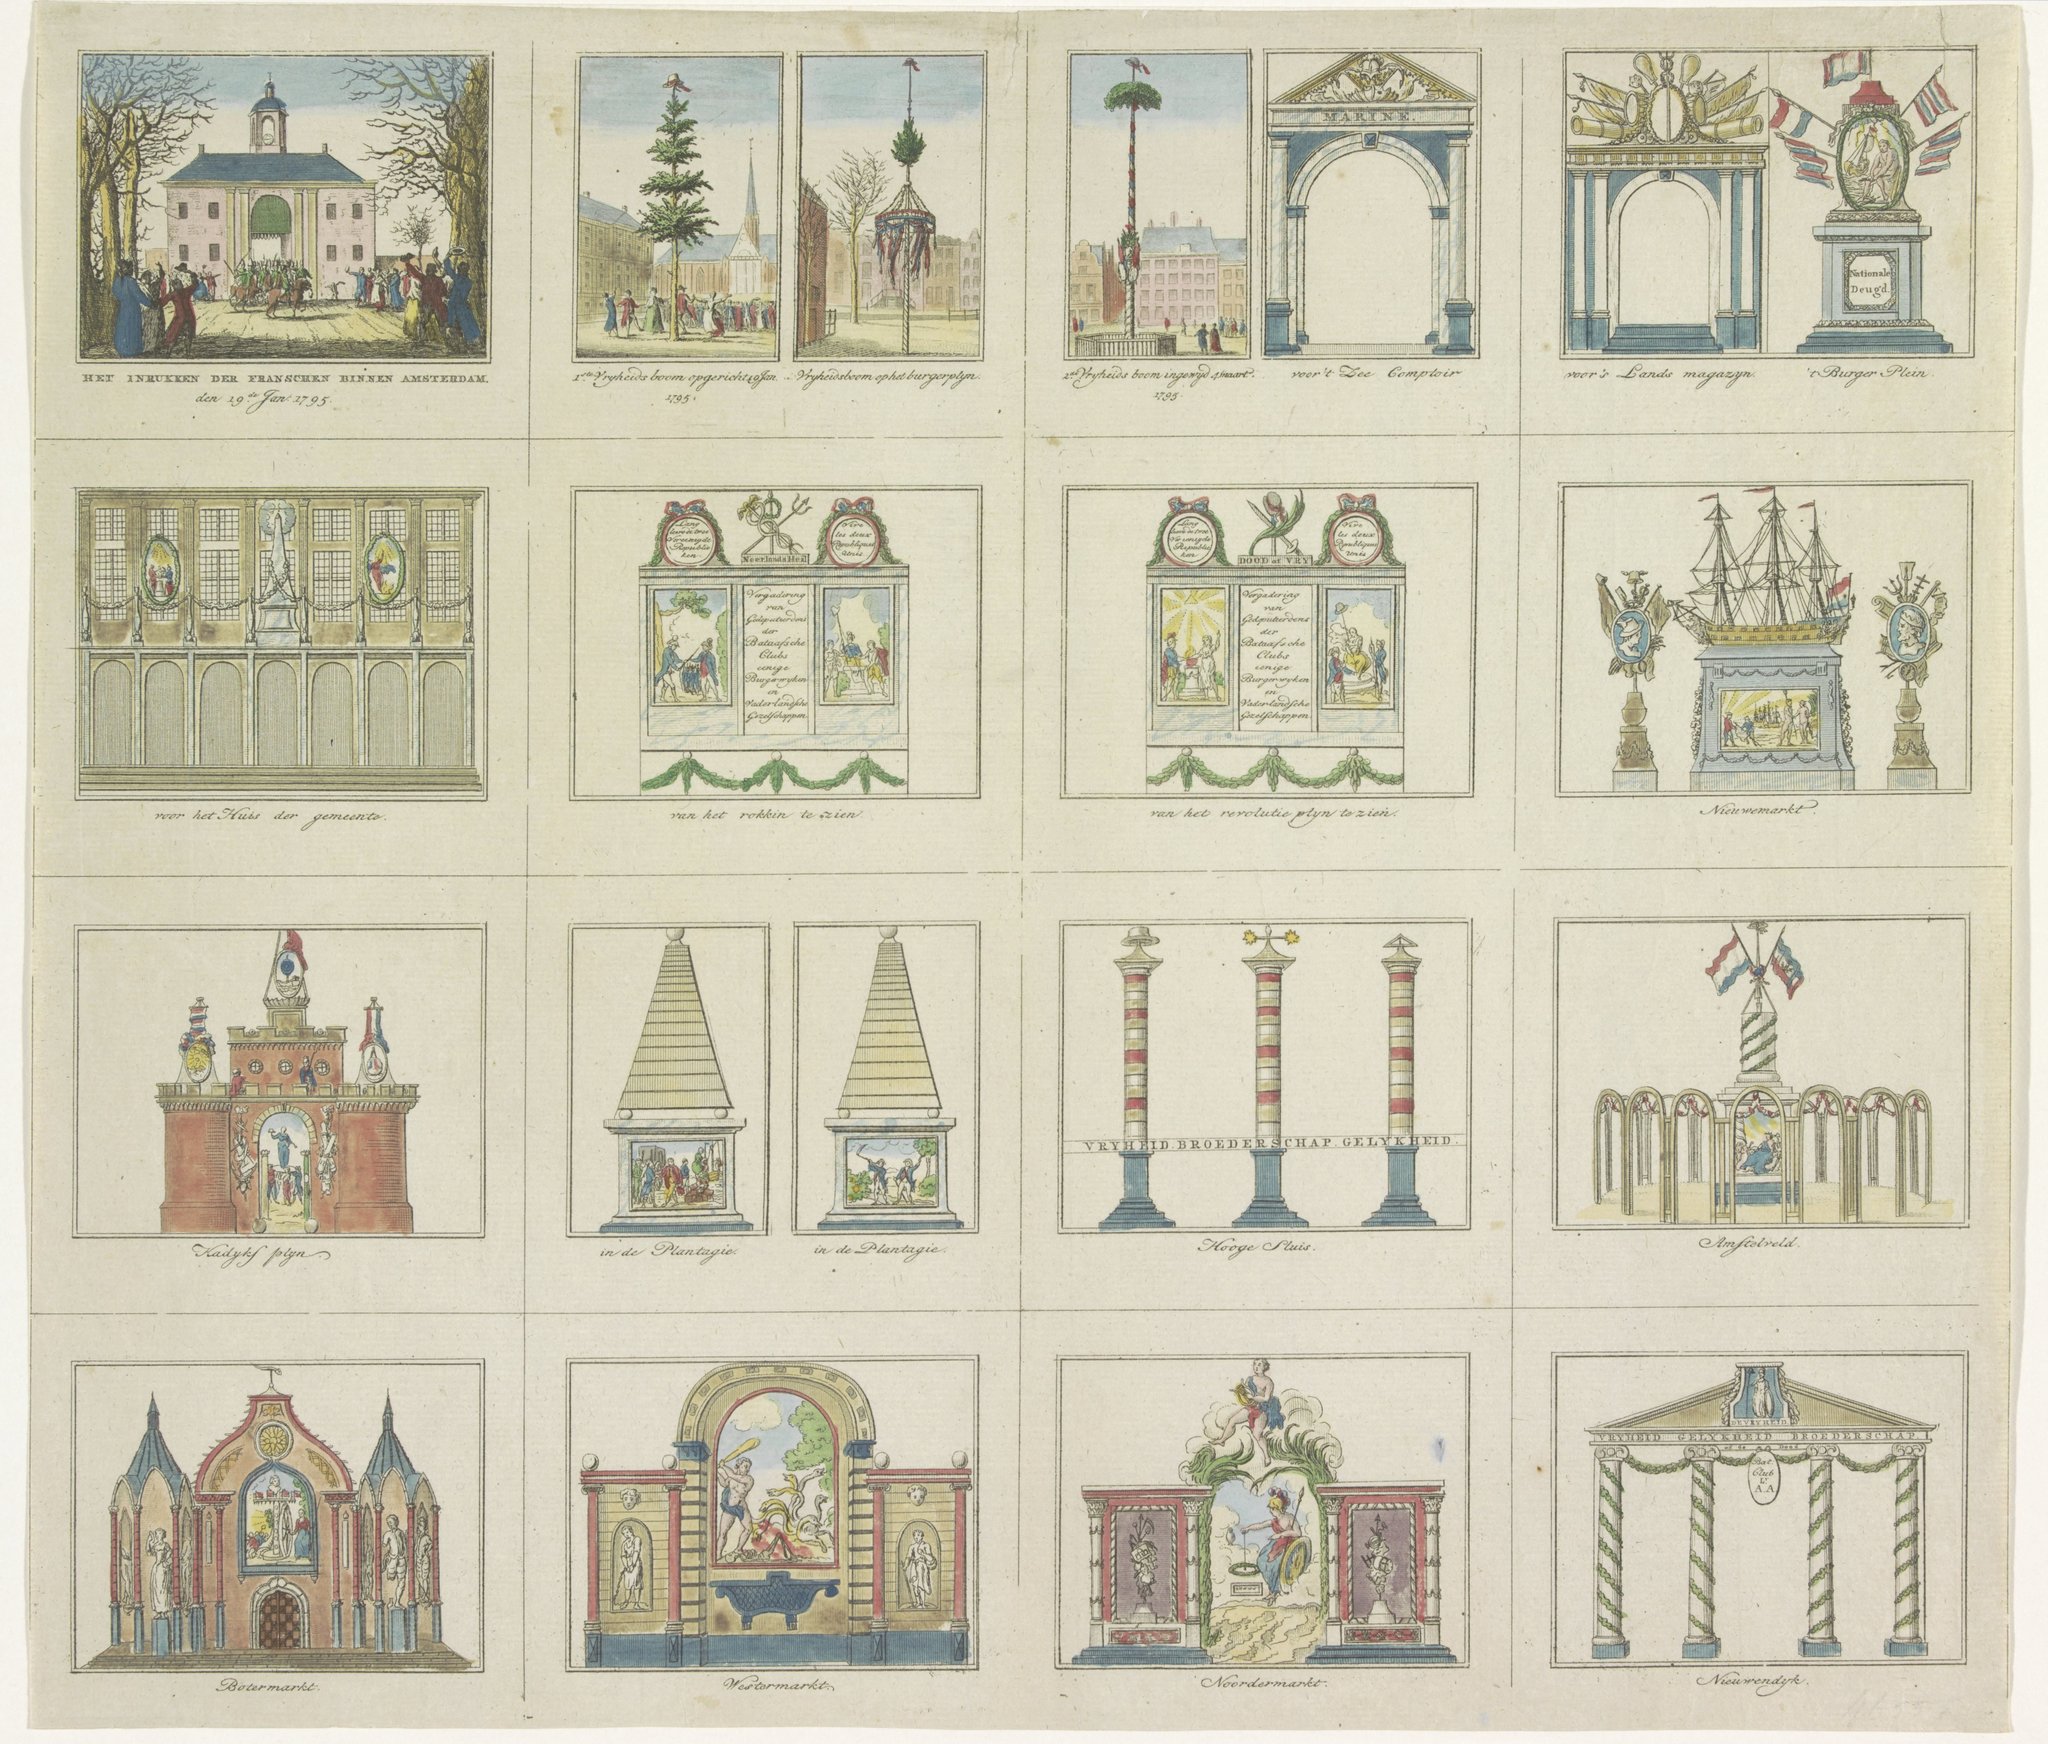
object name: print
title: Overzichtsblad met de decoraties bij het Alliantiefeest te Amsterdam, 1795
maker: Anonymous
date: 1795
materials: paper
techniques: etching, hand coloring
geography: netherlands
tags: festivities on events of national importance (+ festive decoration ~ festive activities), amsterdam, alliance with france (1795)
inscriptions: collector's mark: Lugt 2228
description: Overzichtsblad met alle decoraties opgericht bij het Alliantiefeest te Amsterdam op 19 juni 1795. Ook met de drie vrijheidsbomen eerder opgericht in de stad en een voorstelling van het intrekken van de Franse troepen door de Leidsepoort op 19 januari 1795. Onversneden blad met de voorstellingen verdeeld over zestien vakken.